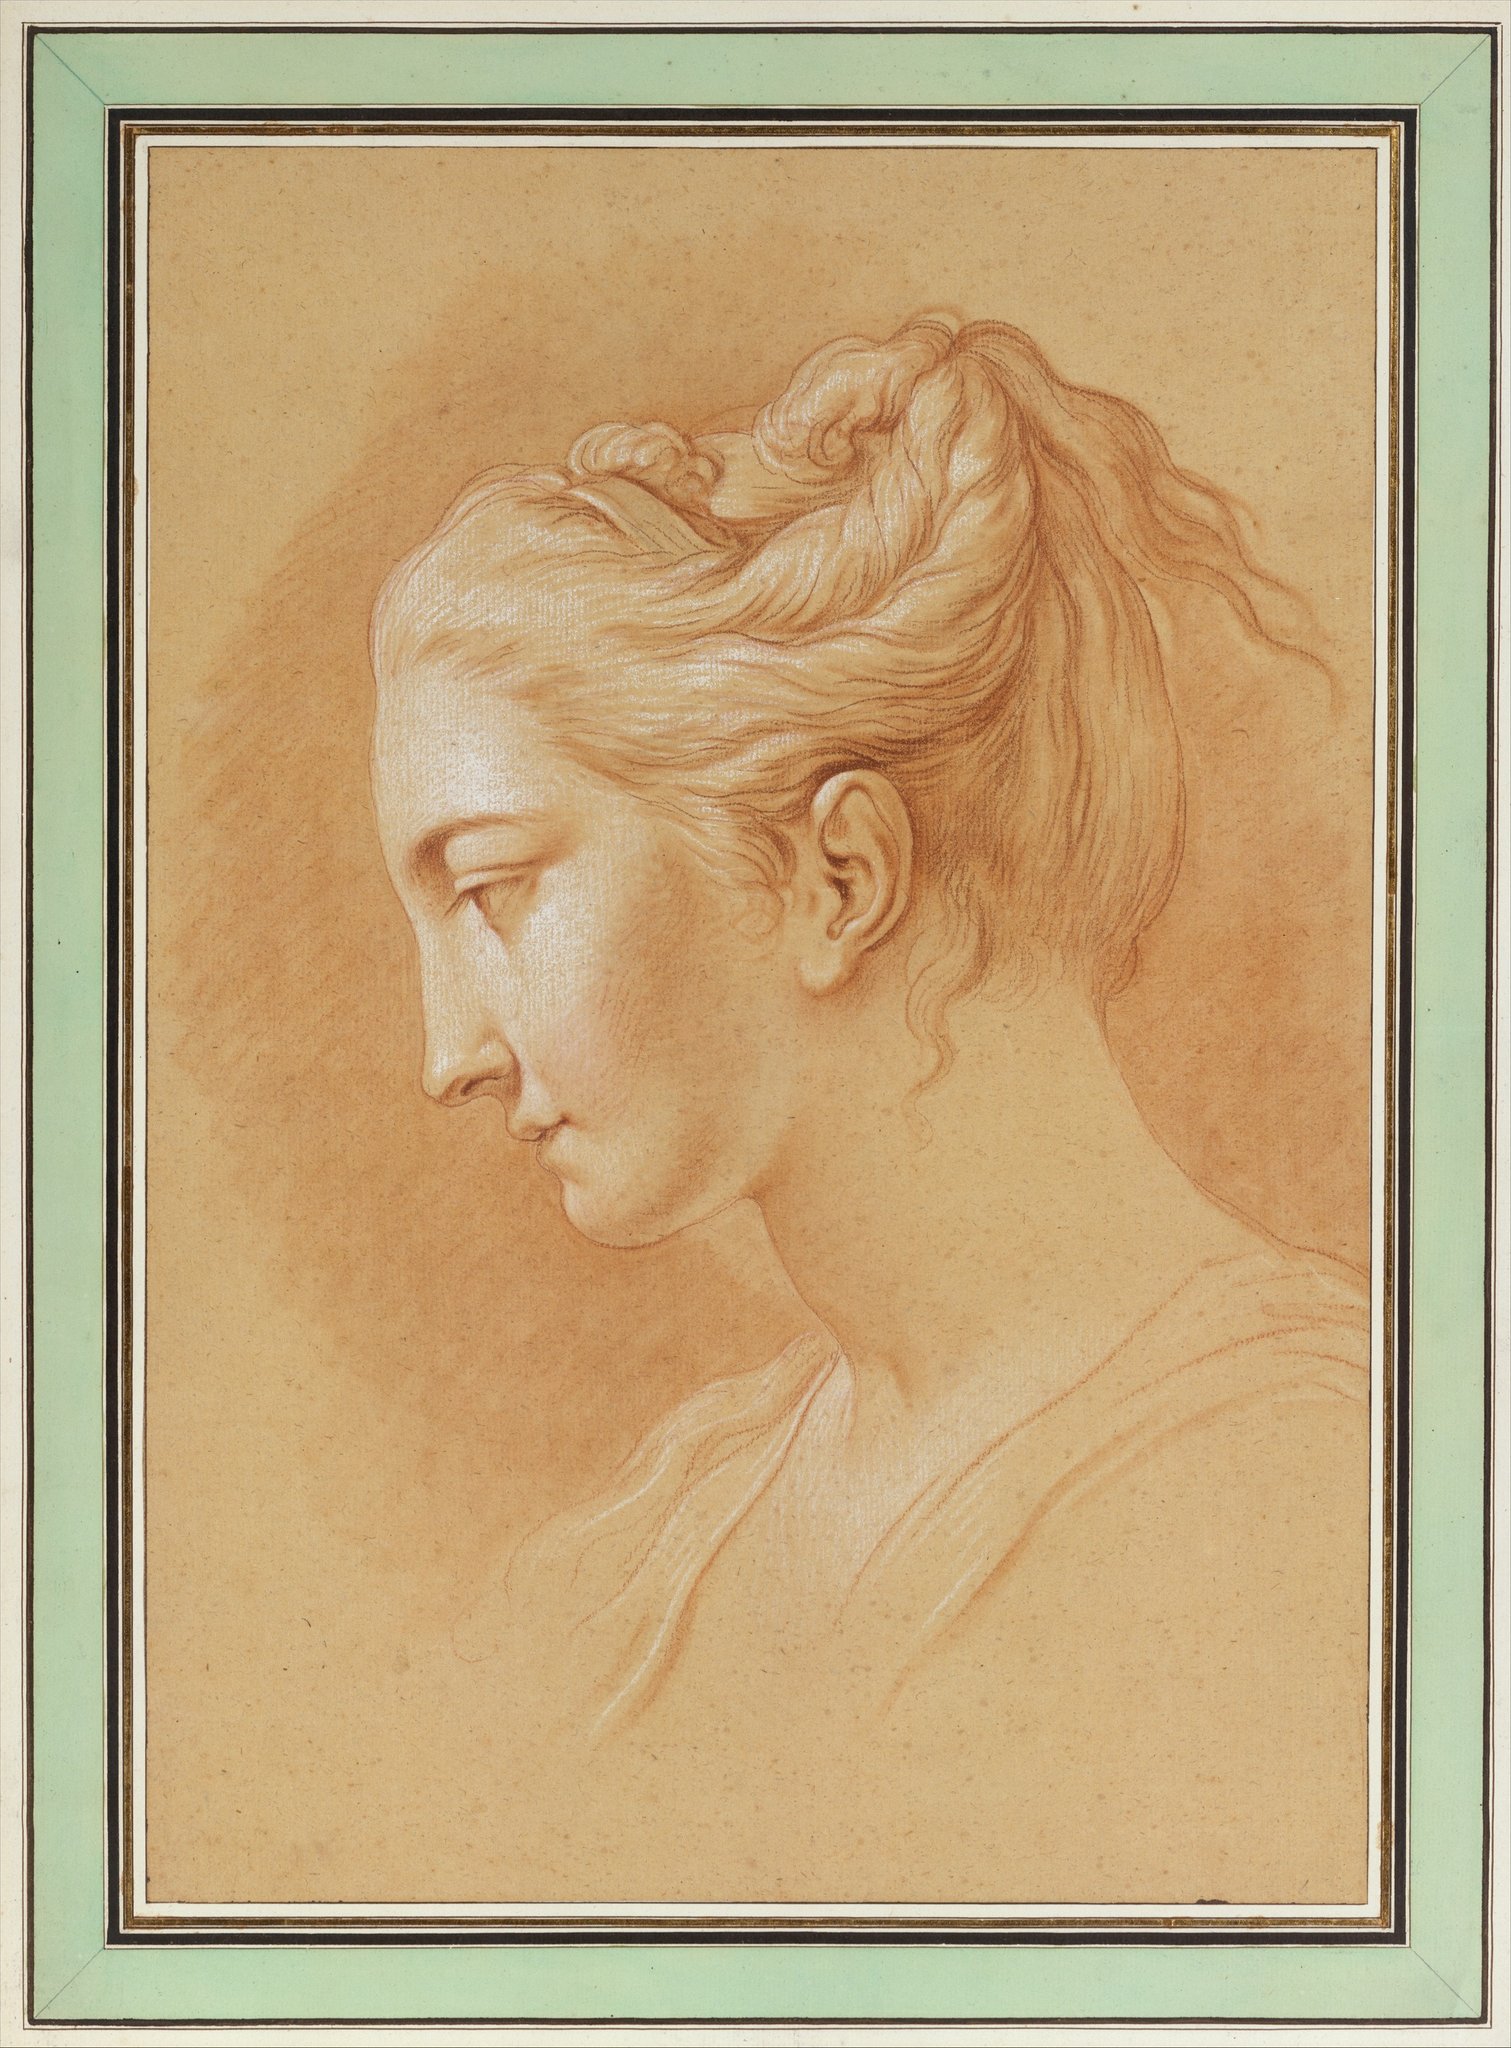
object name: drawing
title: Head of a Young Woman in Profile to Left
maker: jacques philippe joseph de saint quentin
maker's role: artist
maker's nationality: french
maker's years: 1738-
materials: chalk, ink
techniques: heightening, pen, stumping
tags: heads,women